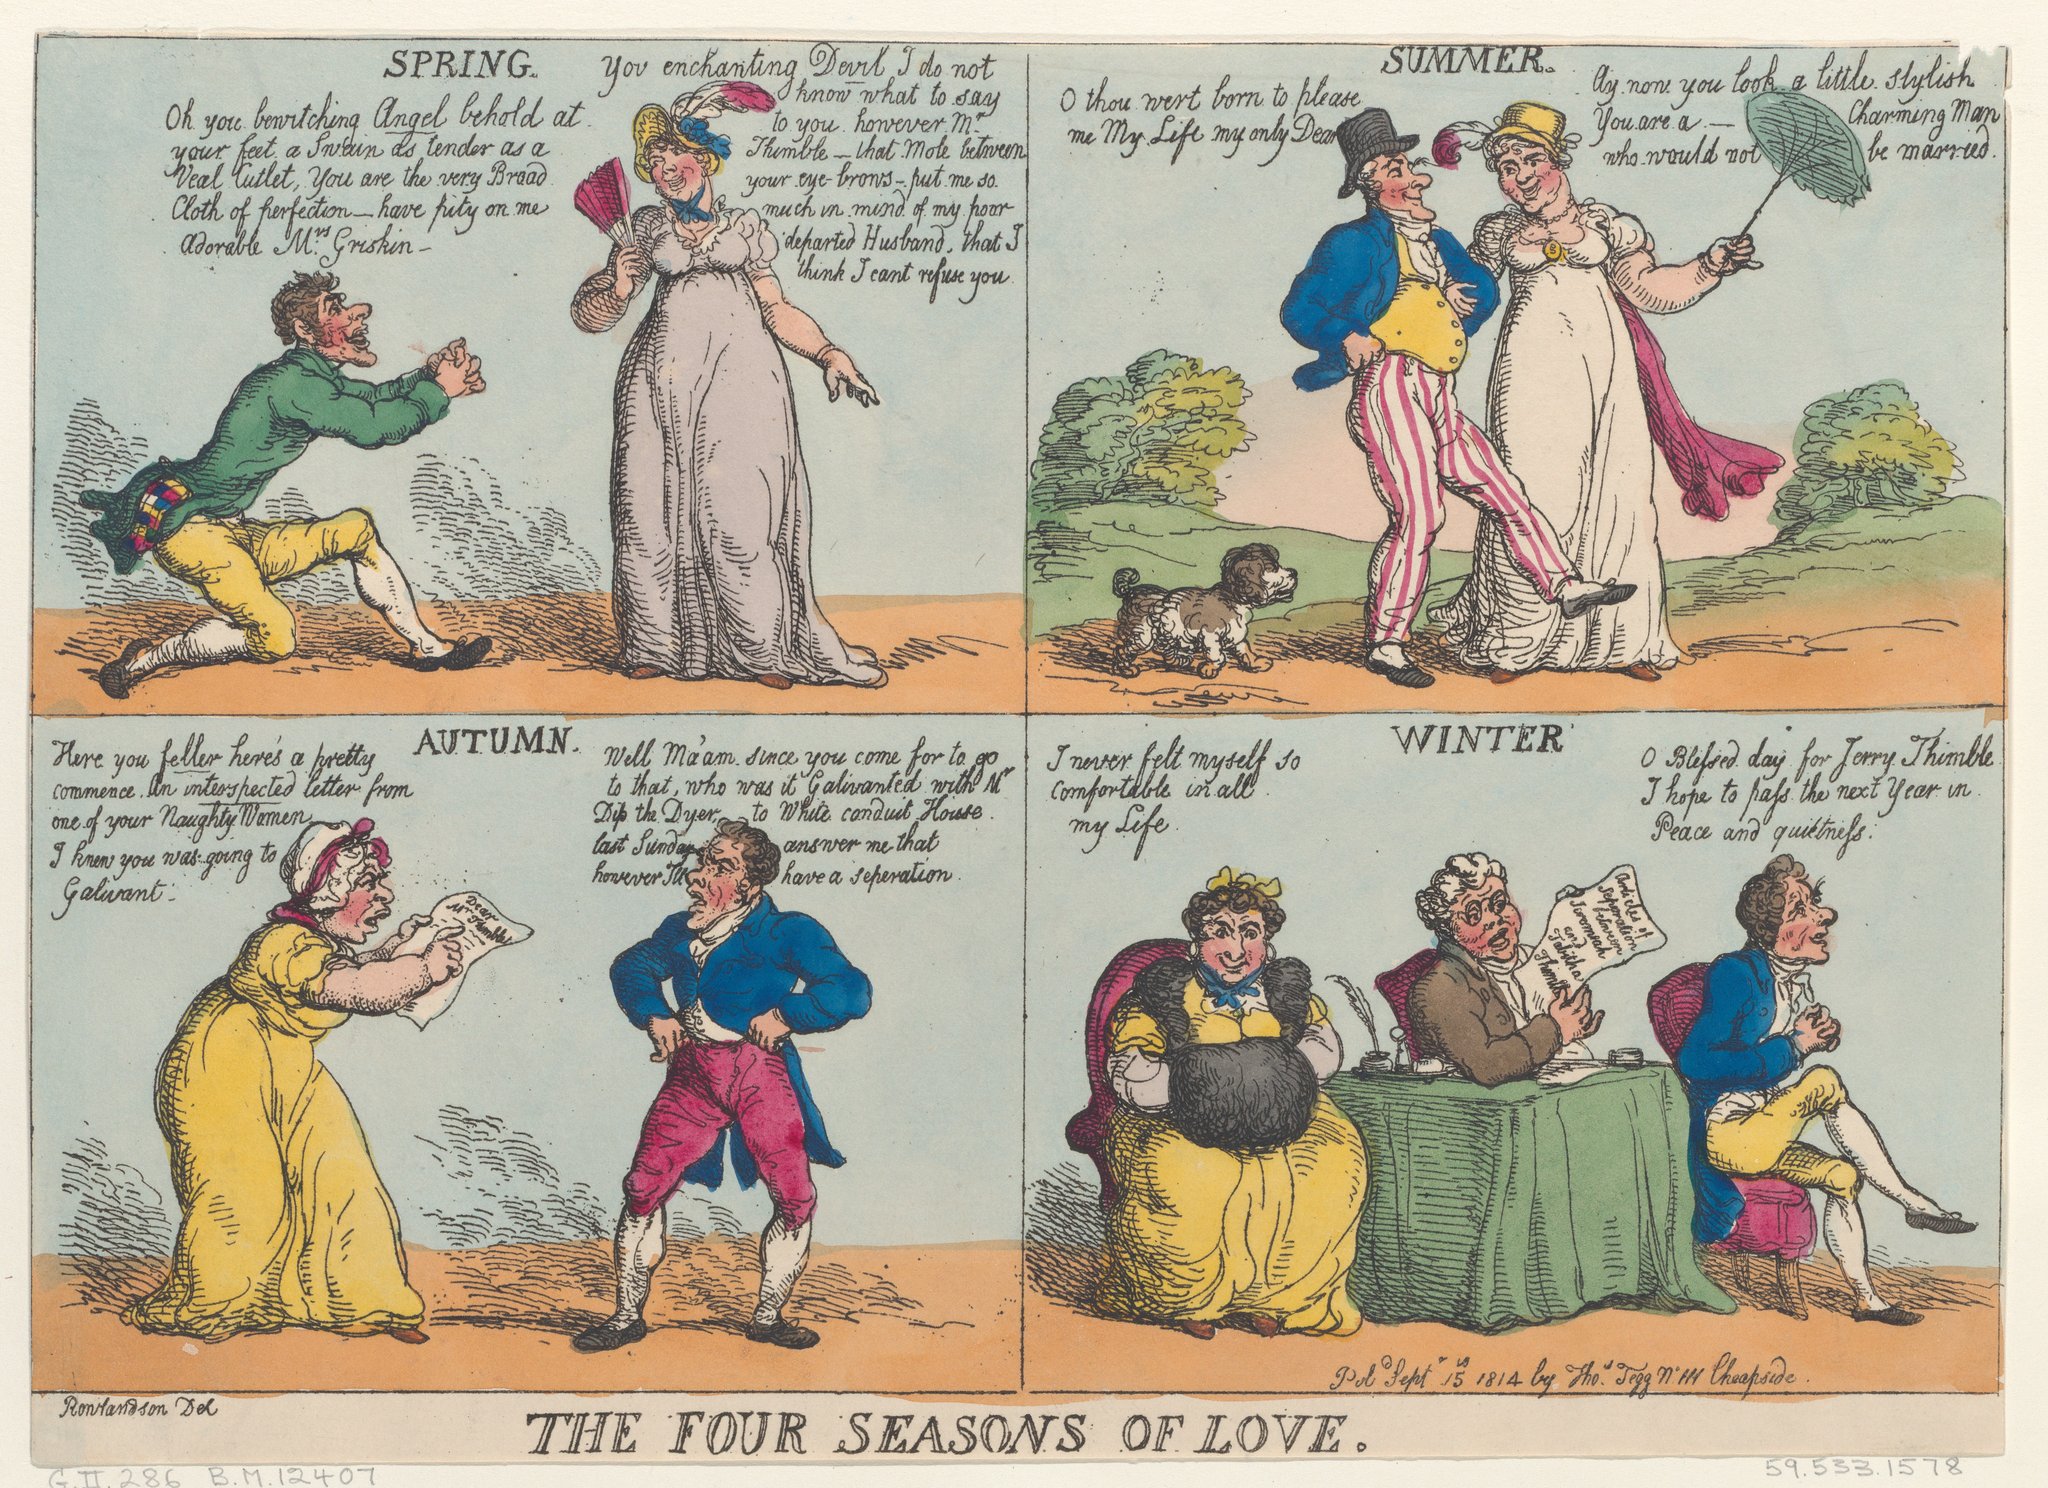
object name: print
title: The Four Seasons of Love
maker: thomas rowlandson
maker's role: artist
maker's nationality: british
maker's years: 1757-1827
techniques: etching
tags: satire,men,women